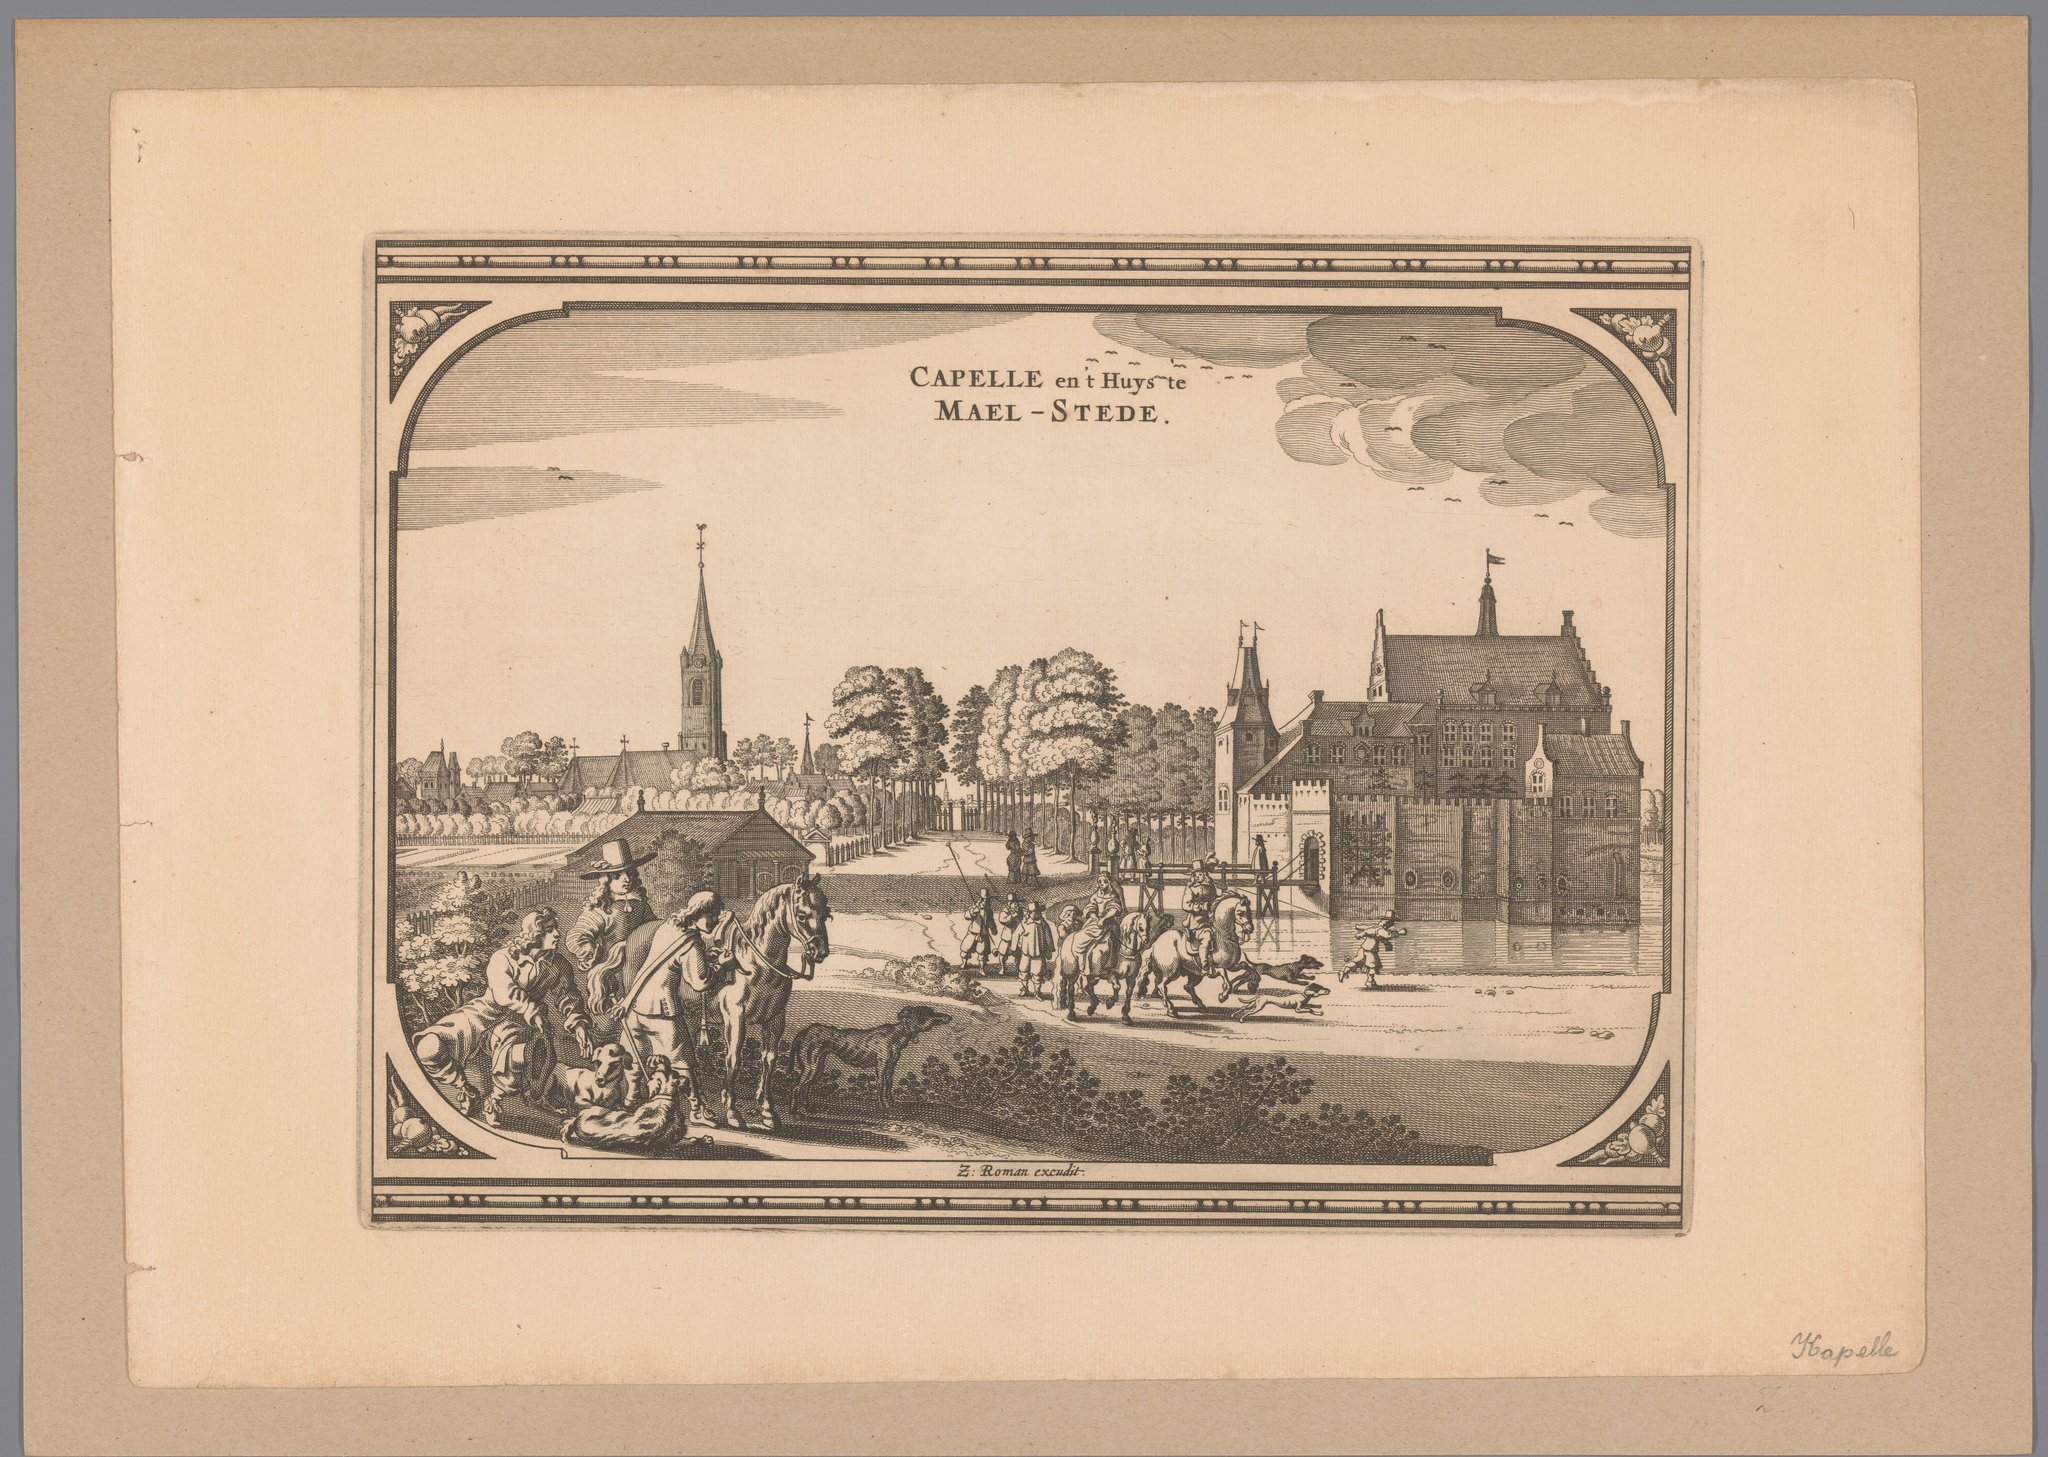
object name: print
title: Gezicht op Kapelle en Kasteel Maalstede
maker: pieter hendricksz. schut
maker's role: print maker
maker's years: 1618-1660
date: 1656-1657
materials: paper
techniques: engraving, etching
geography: amsterdam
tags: prospect of village, silhouette of village, castle, church (exterior)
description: Huidige staat van prent gebruikt in: Theatrum praecipuarum urbium ducatus Brabantiae nec non comitatuum Flandriae et Zelandiae. Amsterdam: Nicolaes Visscher (I), 1657. Verwarring rondom de datering kan ontstaan door het feit dat de prenten die voorkomen in de bovengenoemde publicatie ook voorkomen in een eerder uitgegeven publicatie, waar ze later in zijn ingebonden (Boxhorn, Marcus Zuerius van. Chroniick van Zeelandt (…). 2 dln. Middelburg: Zacharias Roman, 1644. Zie RP-P-AO-15-108-1 rechtsboven voor derde staat.